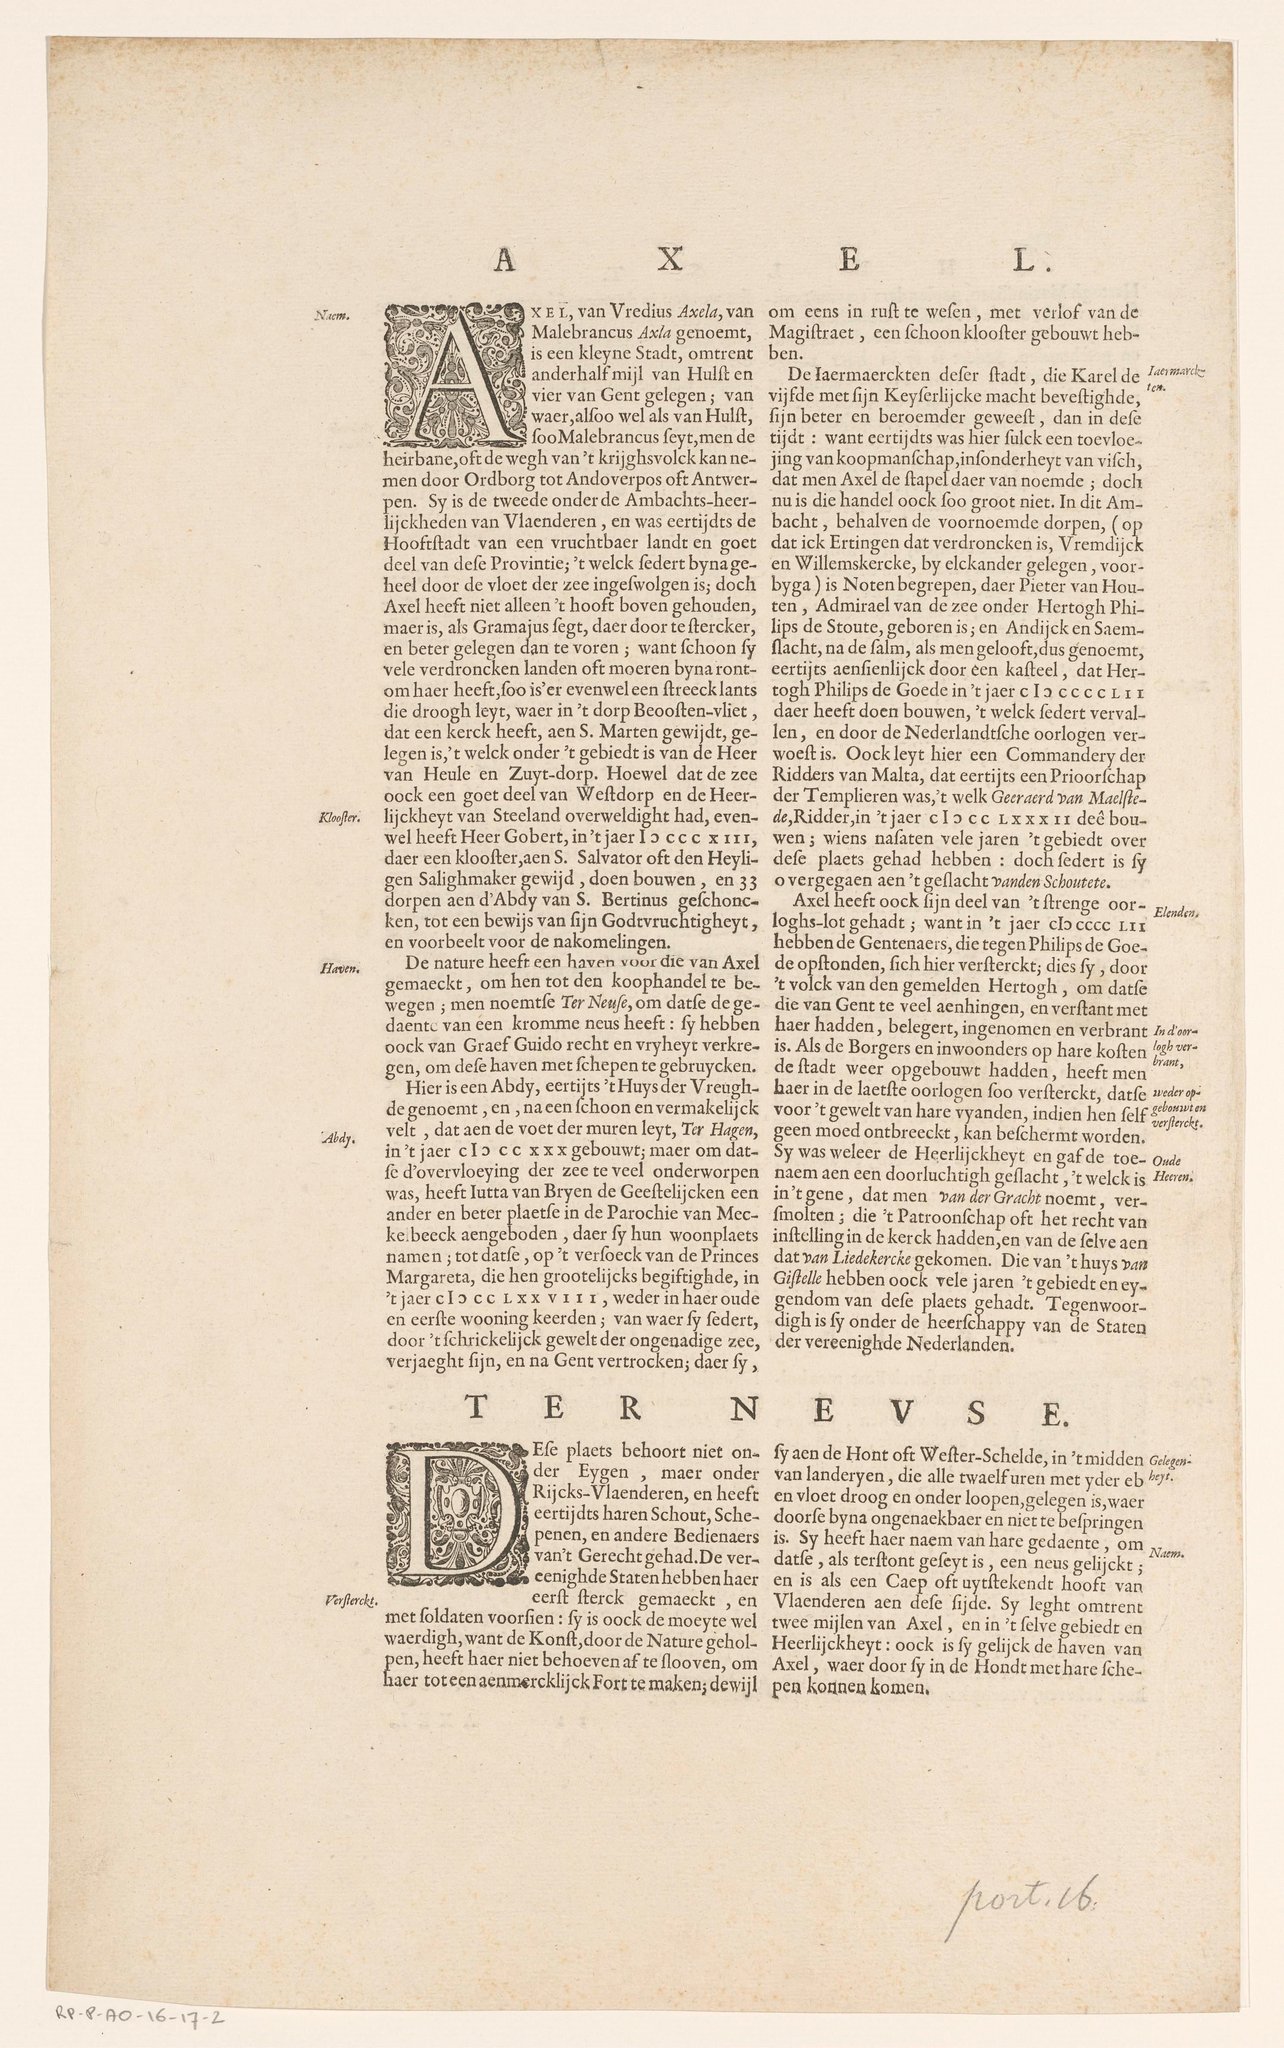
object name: text sheet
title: Beschrijving van Hulst, Liefkenshoek, Axel en Terneuzen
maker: johannes willemszoon blaeu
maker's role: printer, publisher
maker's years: 1596-1673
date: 1652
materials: paper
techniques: letterpress printing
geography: amsterdam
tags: terneuzen, fort liefkenshoek, hulst, axel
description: Tekst gebruikt in: Blaeu, Johannes Willemszoon. Novum ac magnum theatrum urbium Belgicae (...). 2 delen. 3e druk. Amsterdam: Johannes Willemszoon Blaeu, 1652, dl. 1.